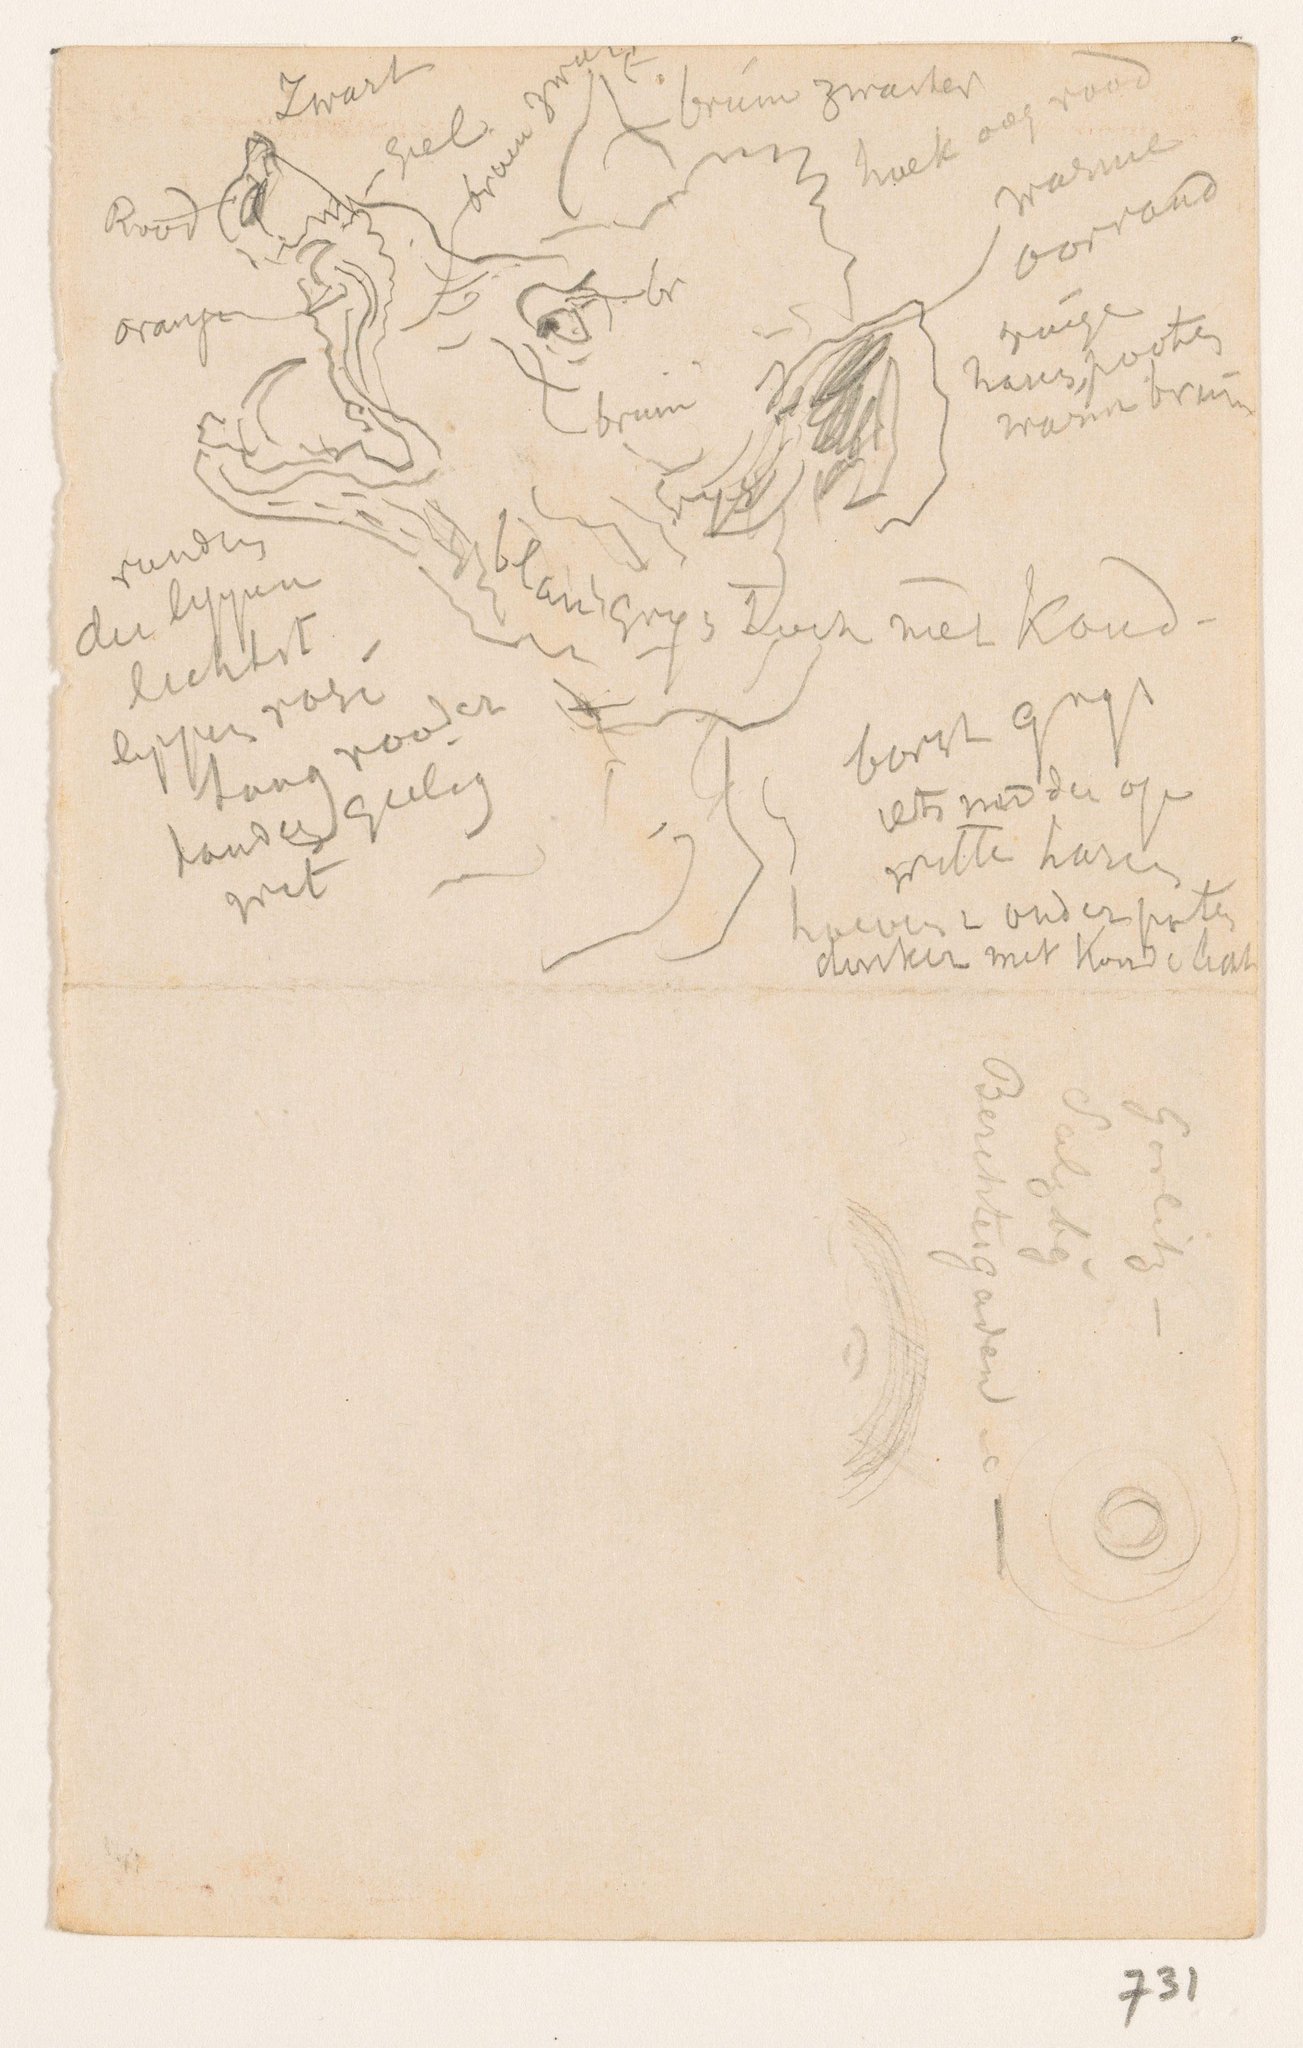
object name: drawing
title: Kop van een wolf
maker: johannes tavenraat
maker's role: draughtsman, painter, print maker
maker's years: 1809-1881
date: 1840-1880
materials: paper, pencil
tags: beasts of prey, predatory animals: wolf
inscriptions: collector's mark: Lugt 2228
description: Kop van een wolf, met notities over de kleuren. Op de achterzijde een handgeschreven recept.